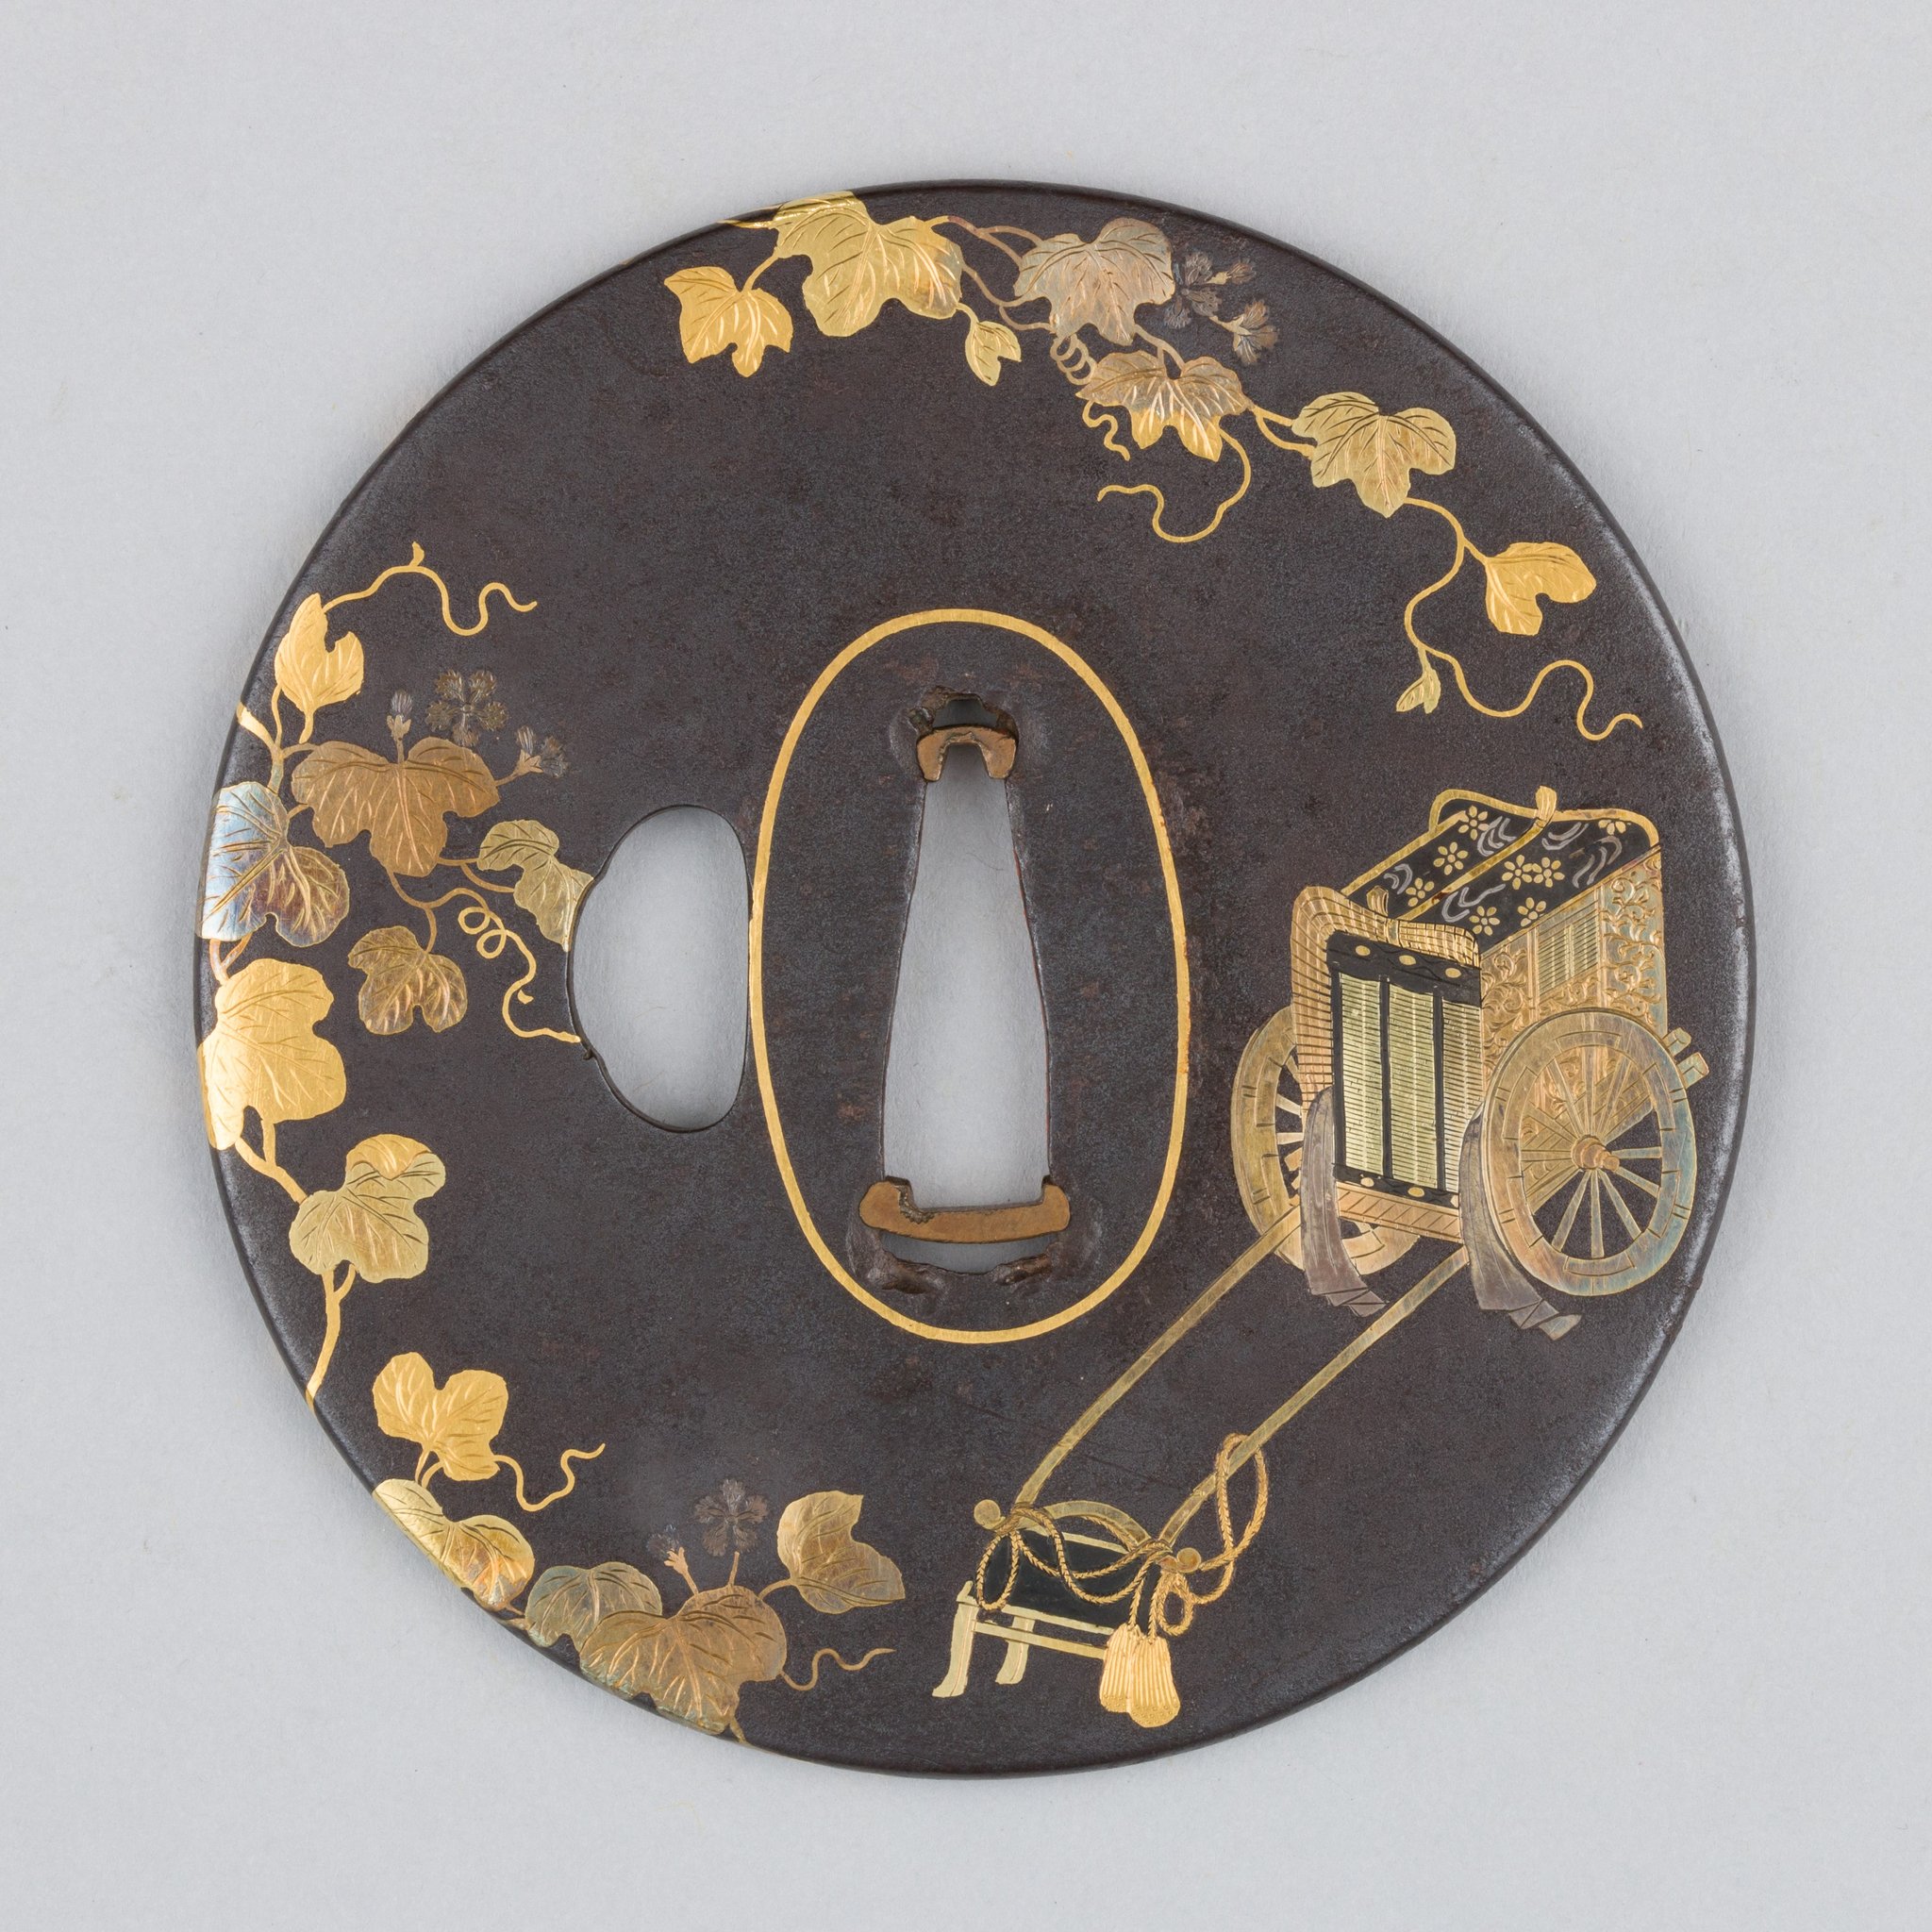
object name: sword guard tsuba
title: Sword Guard (Tsuba)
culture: japanese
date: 1701-1800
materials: copper, gold, iron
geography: japan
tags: leaves,carts